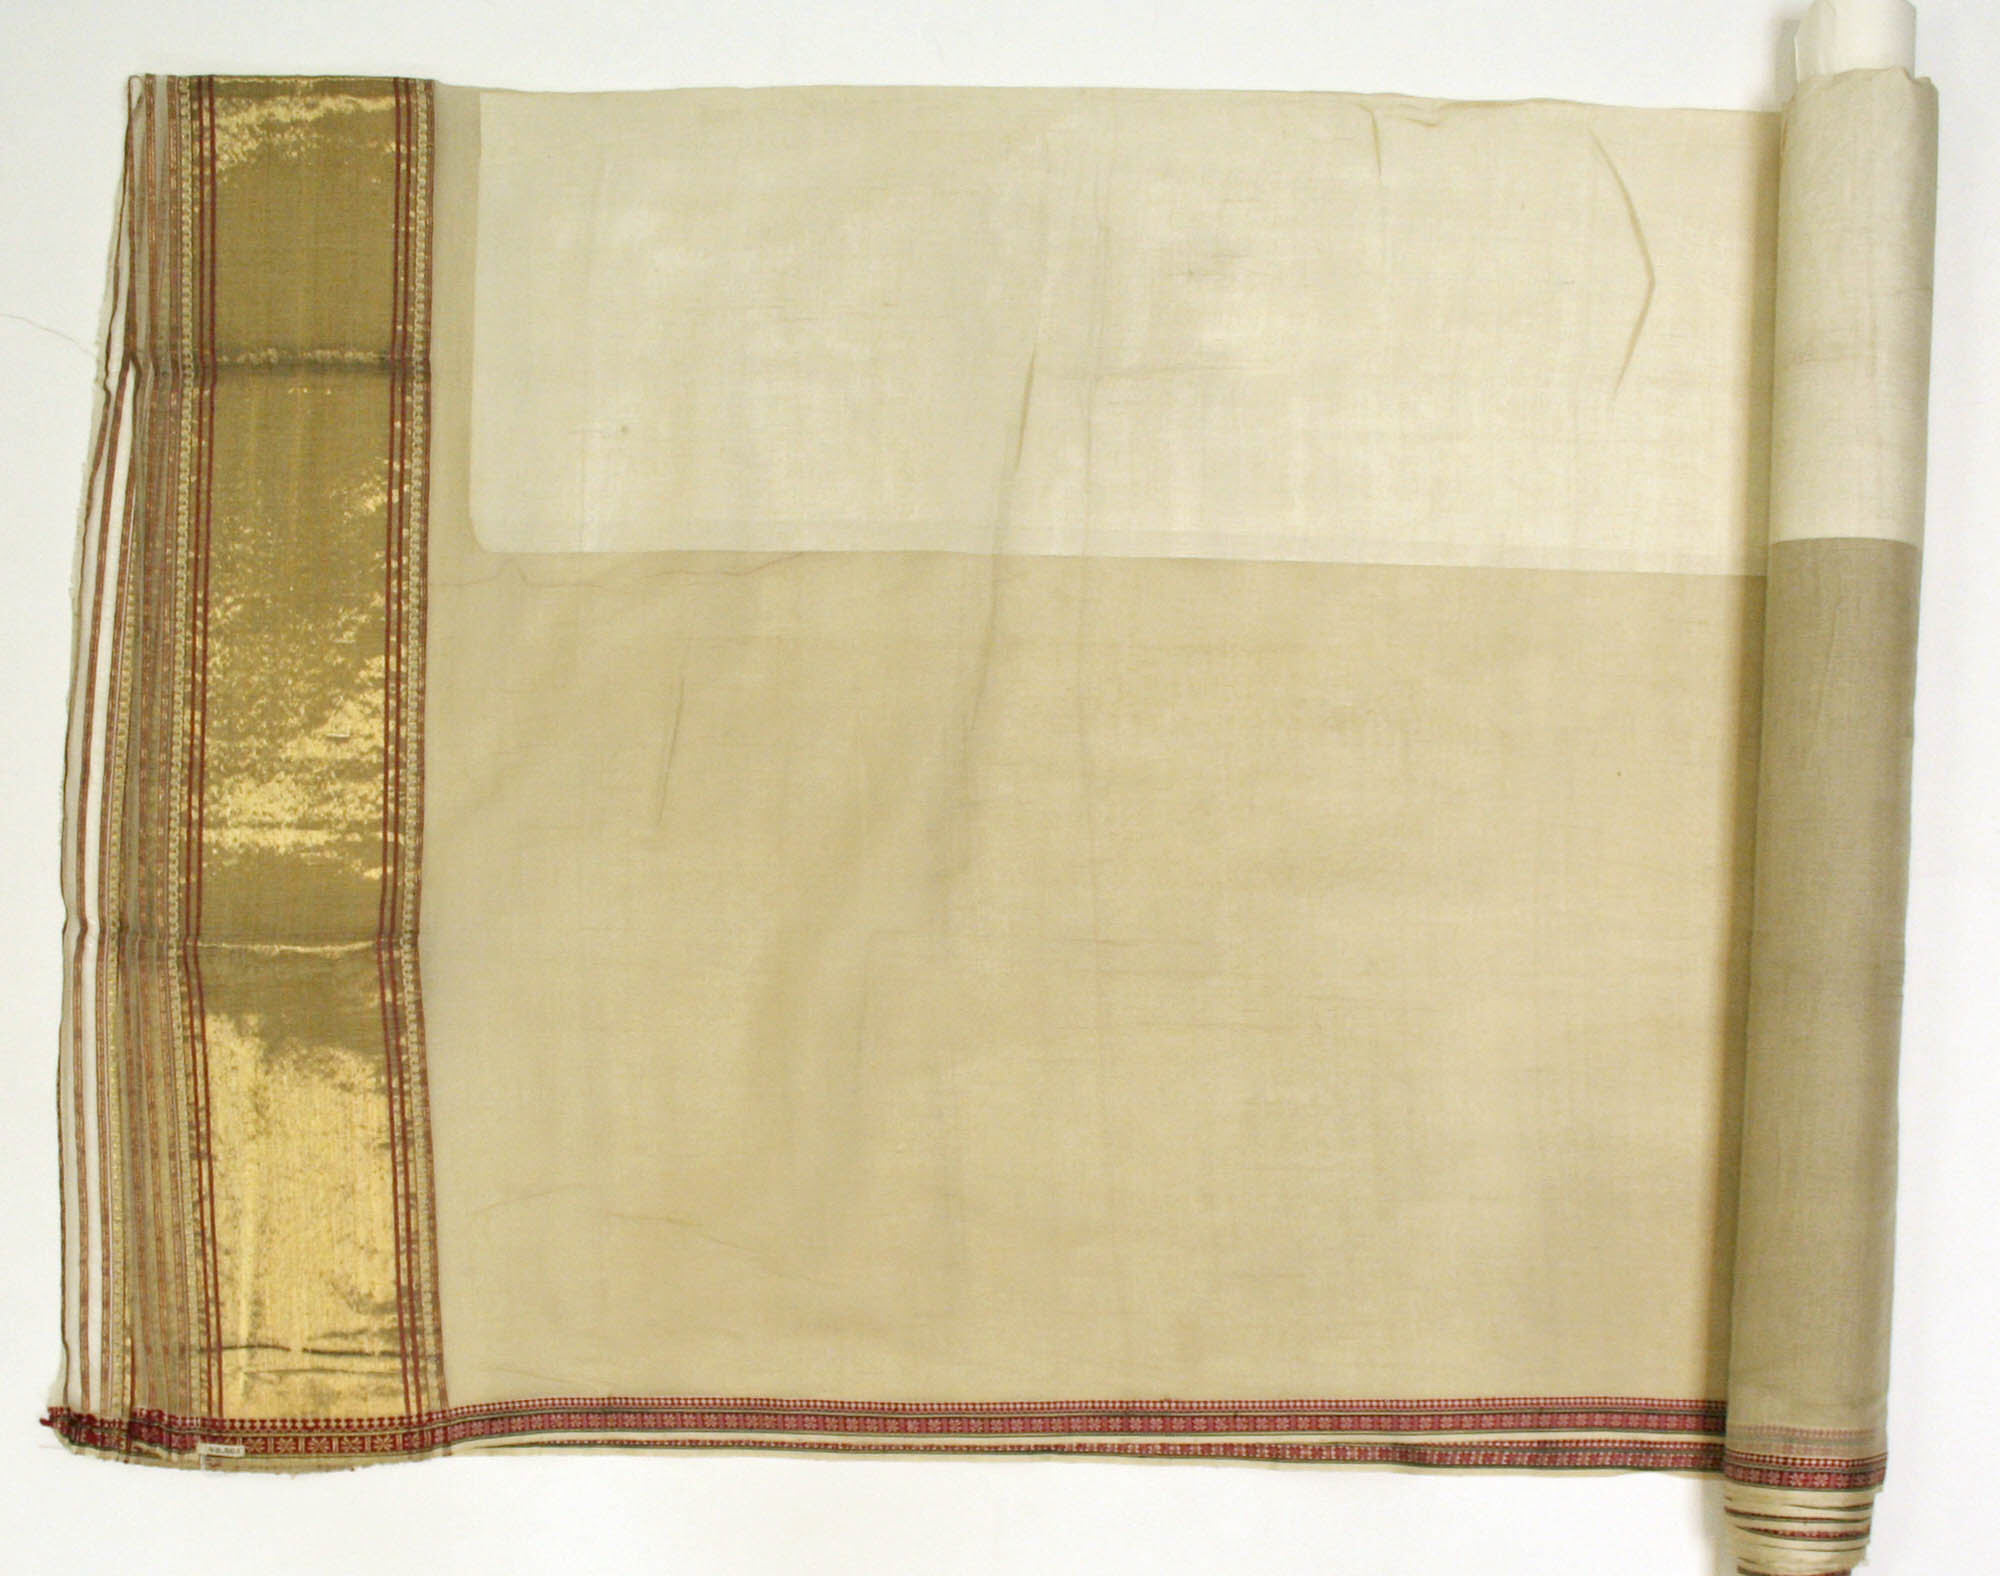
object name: sari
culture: indian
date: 1801-1900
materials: cotton